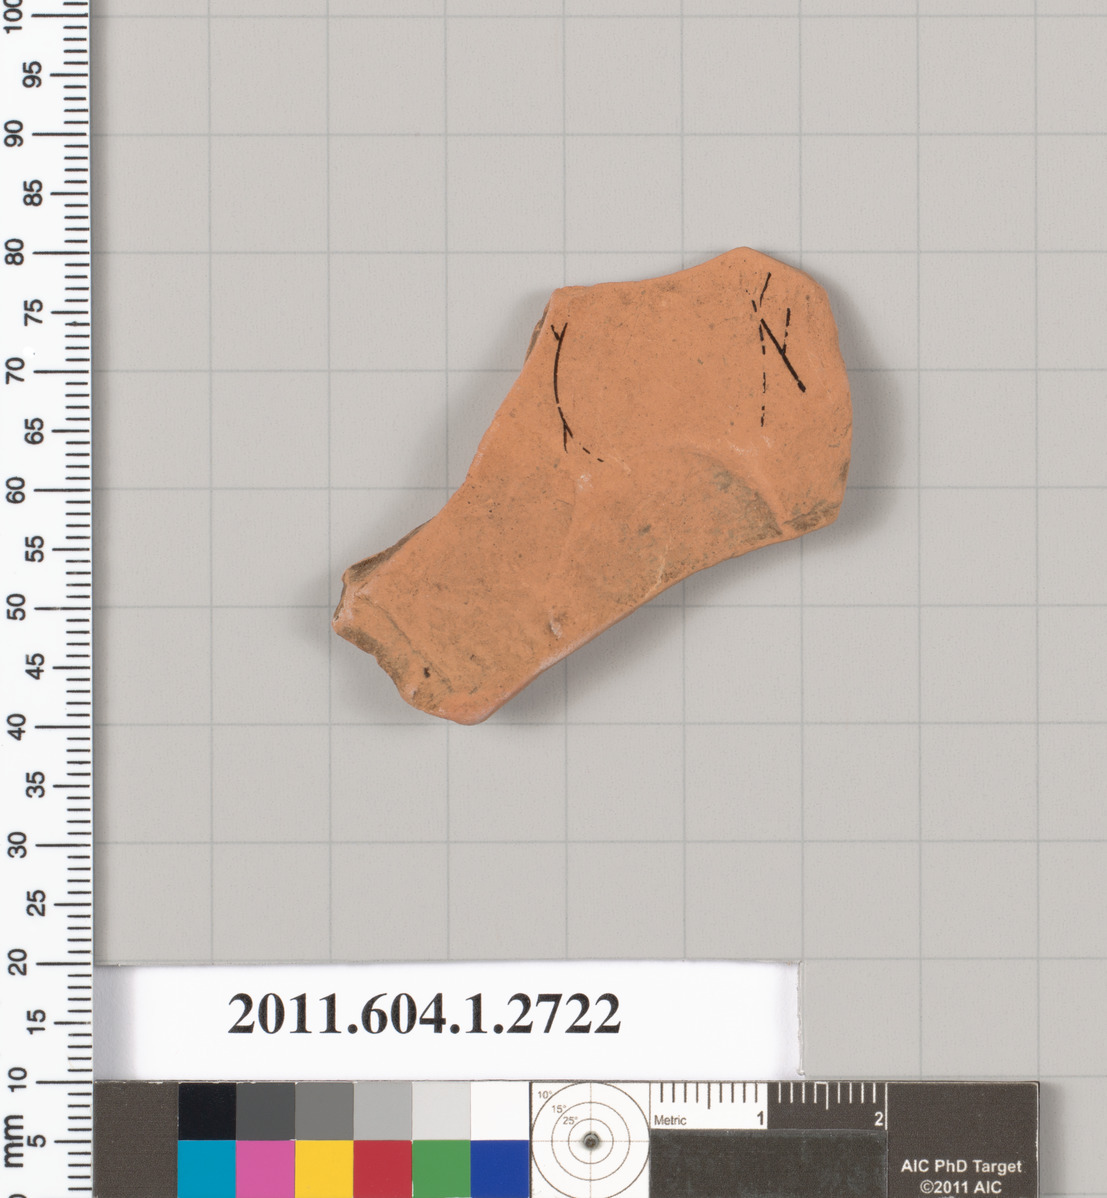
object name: kylix fragment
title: Terracotta fragment of a kylix (drinking cup)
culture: greek, attic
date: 490-480 BCE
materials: terracotta